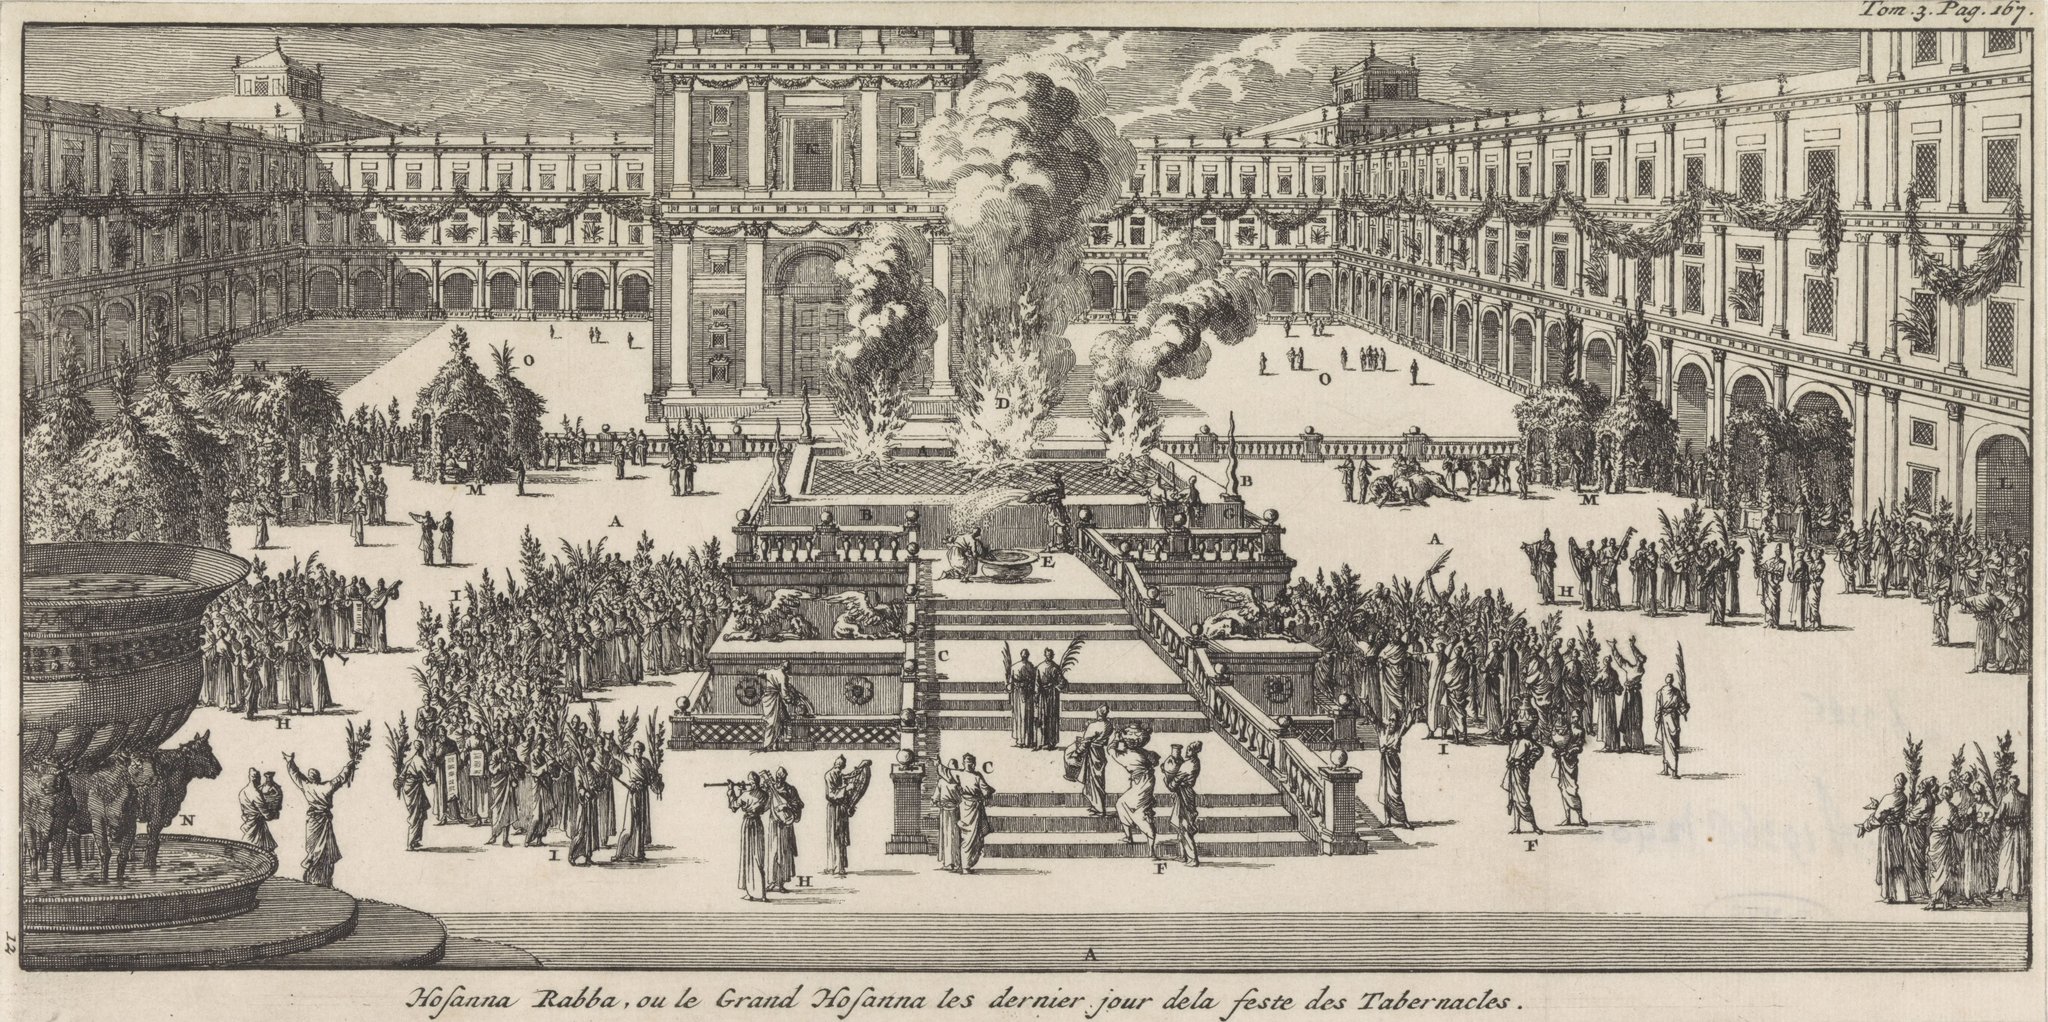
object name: book illustration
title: Hosanna Rabba, ou le Grand Hosanna les dernier jour dela feste des Tabernacles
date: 1705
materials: paper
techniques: etching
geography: amsterdam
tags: 'hoshana rabba' (seventh day of the 'sukkot' festival)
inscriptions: collector's mark: Lugt 2228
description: Illustratie uit: Cunaeus, Petrus. La republique des Hebreux, 3 delen. Amsterdam: Pieter Mortier, 1705, dl. III, p. 167.